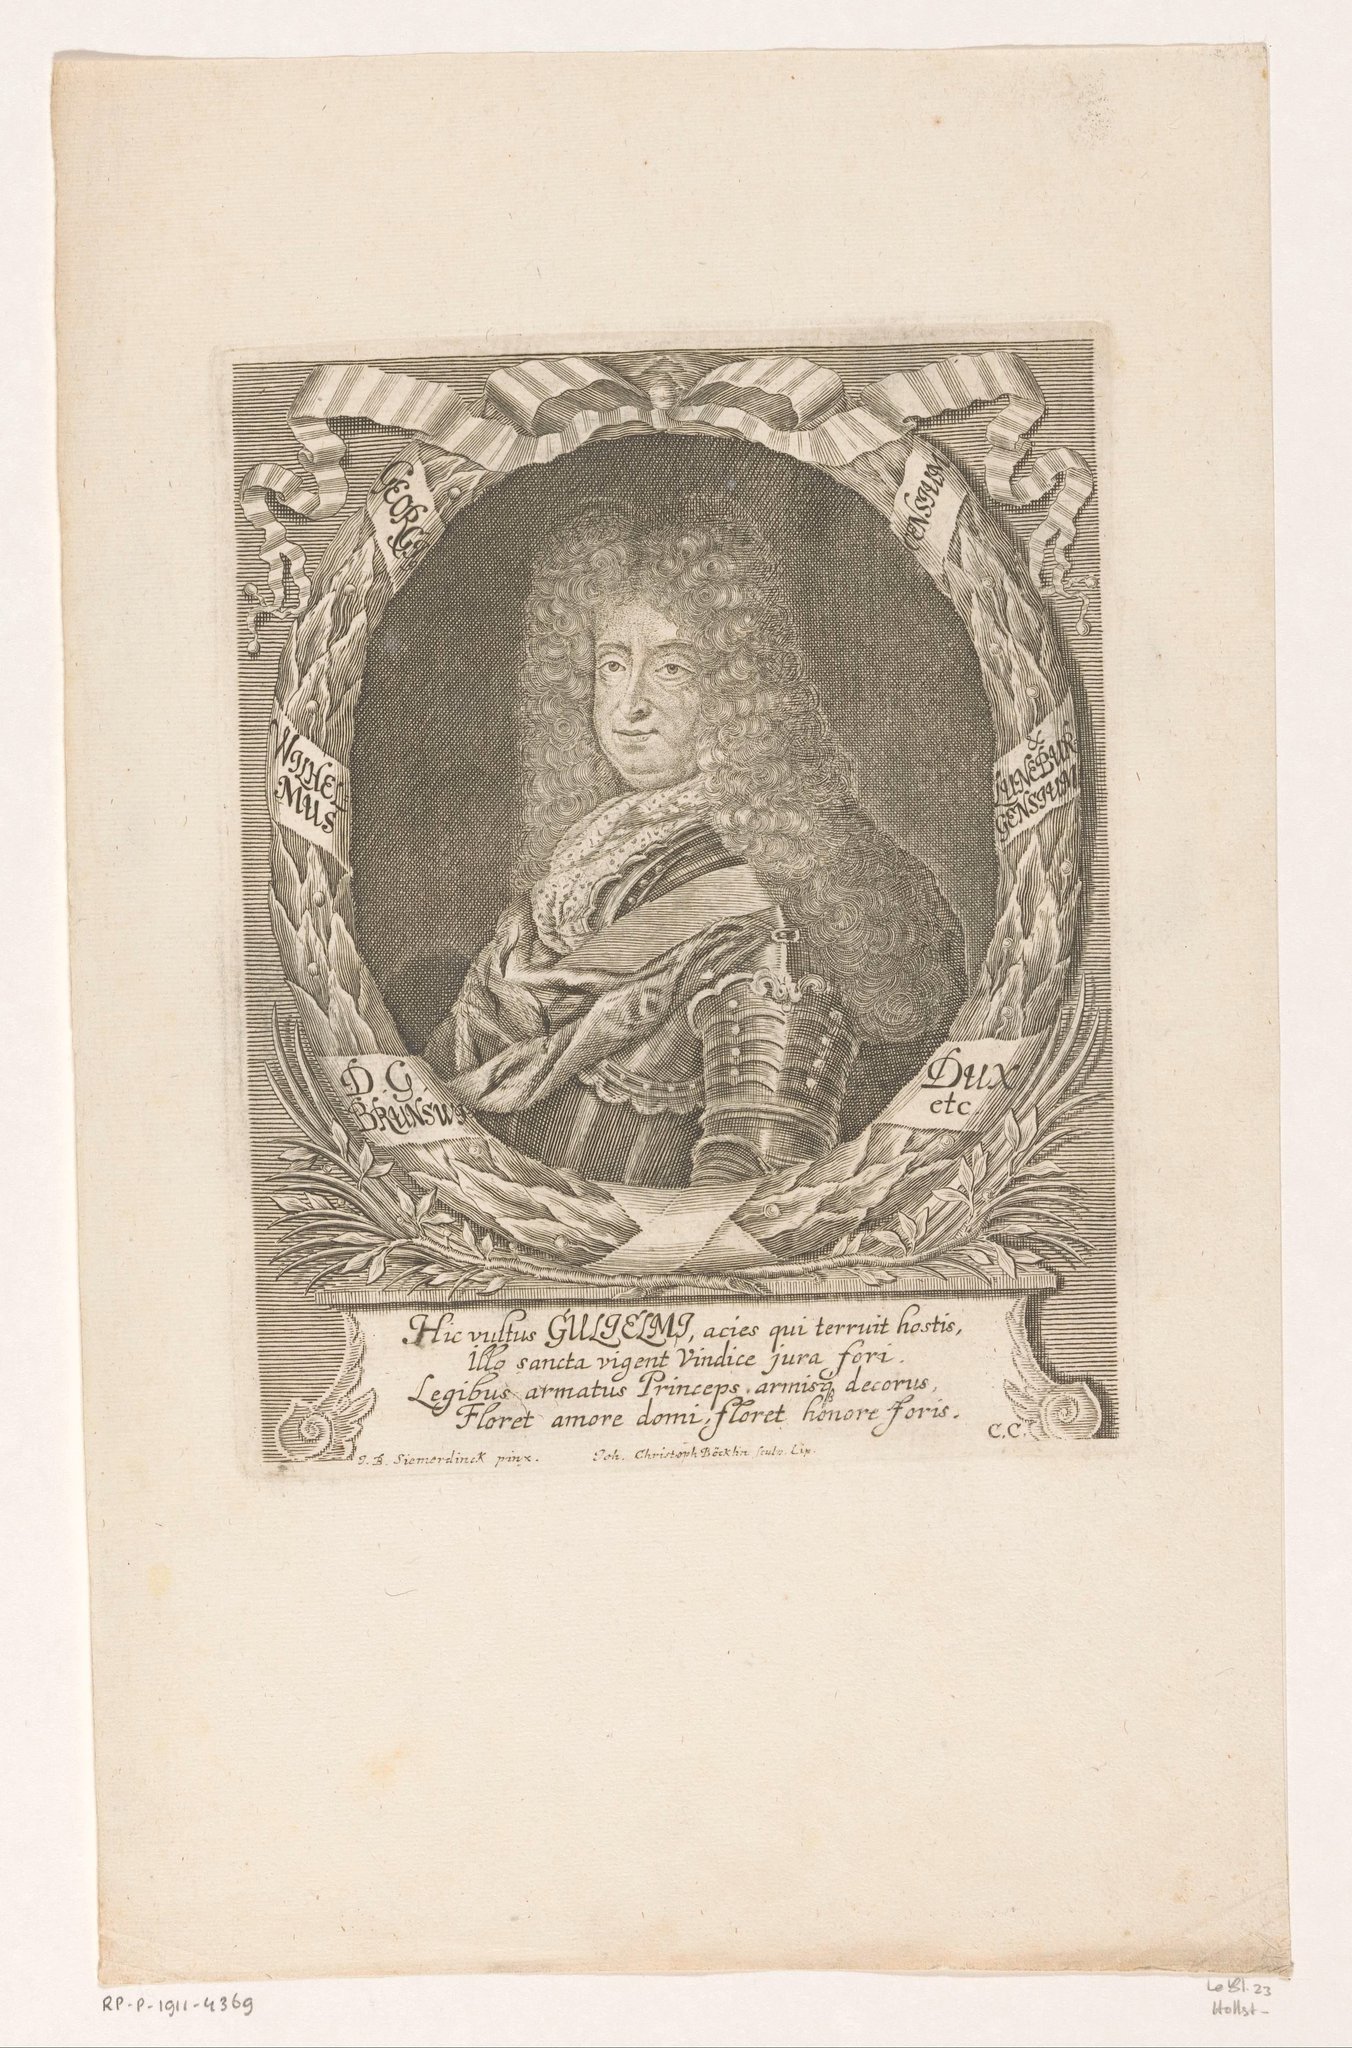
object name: print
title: Portret van Georg Wilhelm von Braunschweig-Lüneburg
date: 1700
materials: paper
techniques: engraving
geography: leipzig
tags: armour, historical persons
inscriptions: collector's mark: Lugt 2228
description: Prent ook gebruikt in: Fürstliche Braunschweig-Lüneb. Zellischen Theils Policey-Ordnung (...), Hannover en Celle: Nicolaus Förster en Hieronymus Friedrich Hoffmann, 1700.